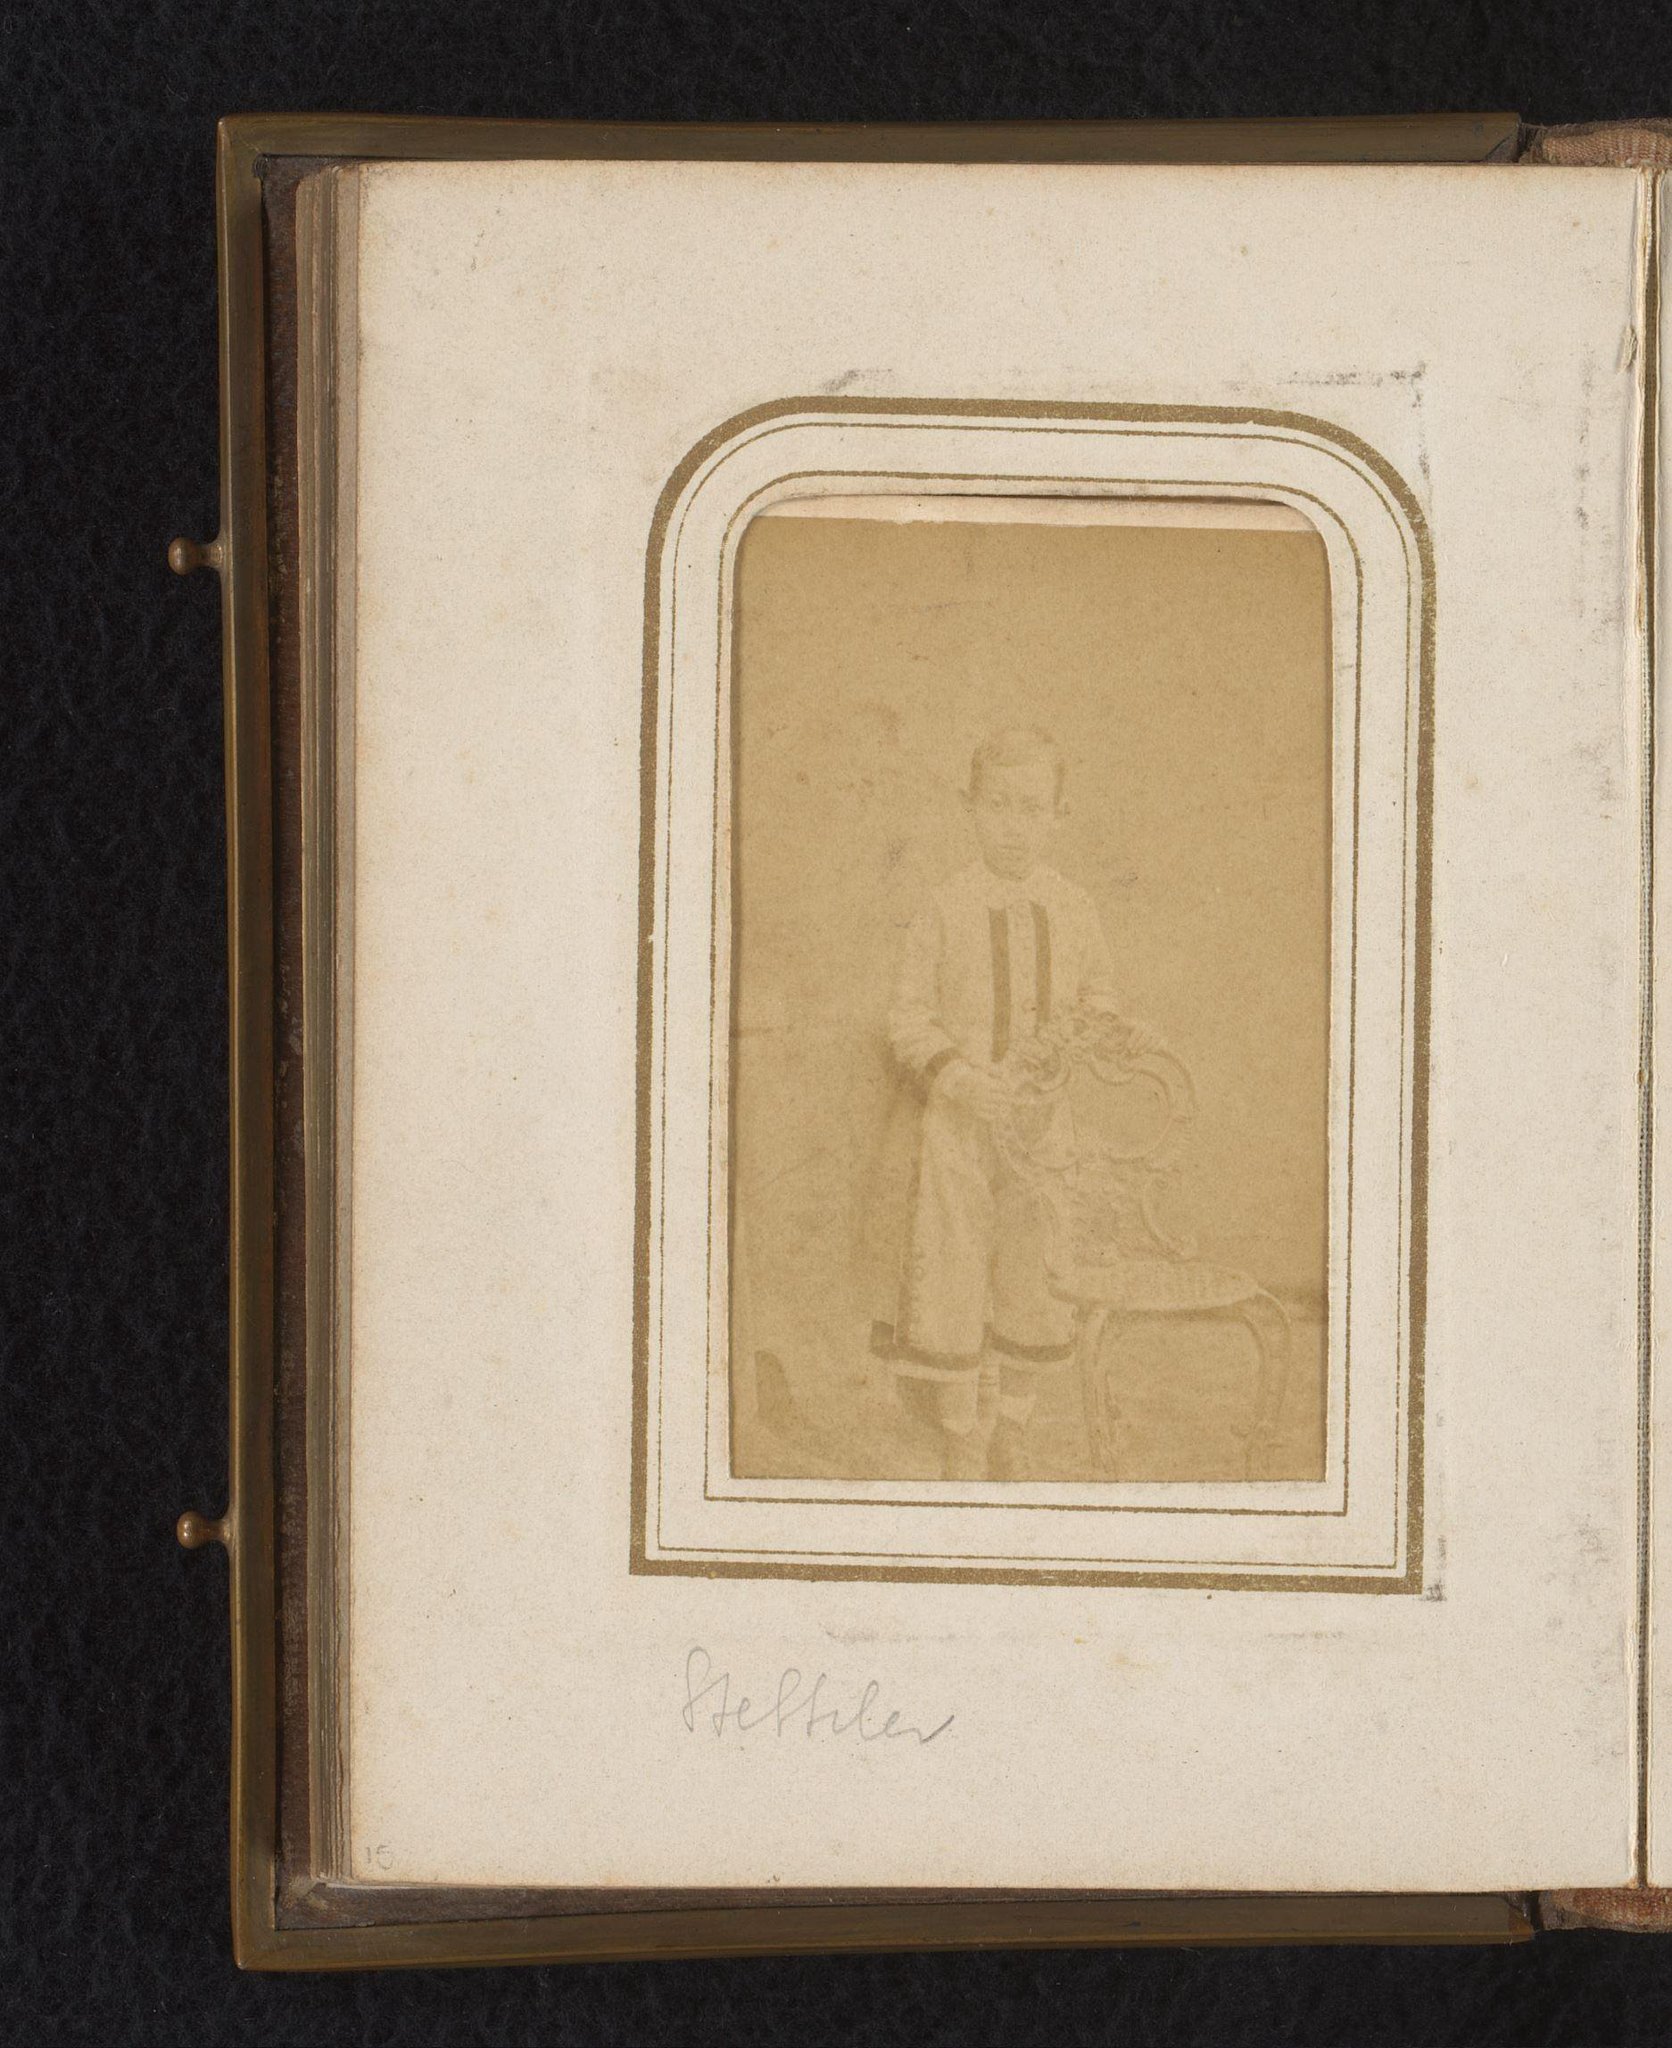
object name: photograph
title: Portret van een jongen, staand bij een stoel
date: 1857-1908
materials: cardboard, photographic support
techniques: albumen print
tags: standing figure, boy (child between toddler and youth), historical persons, chair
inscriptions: annotation: ‘[S.Tebbelen]’, inscription: ‘Woodbury & Page,/ Photographers/ Java’, annotation: ‘[Stebbelen]’